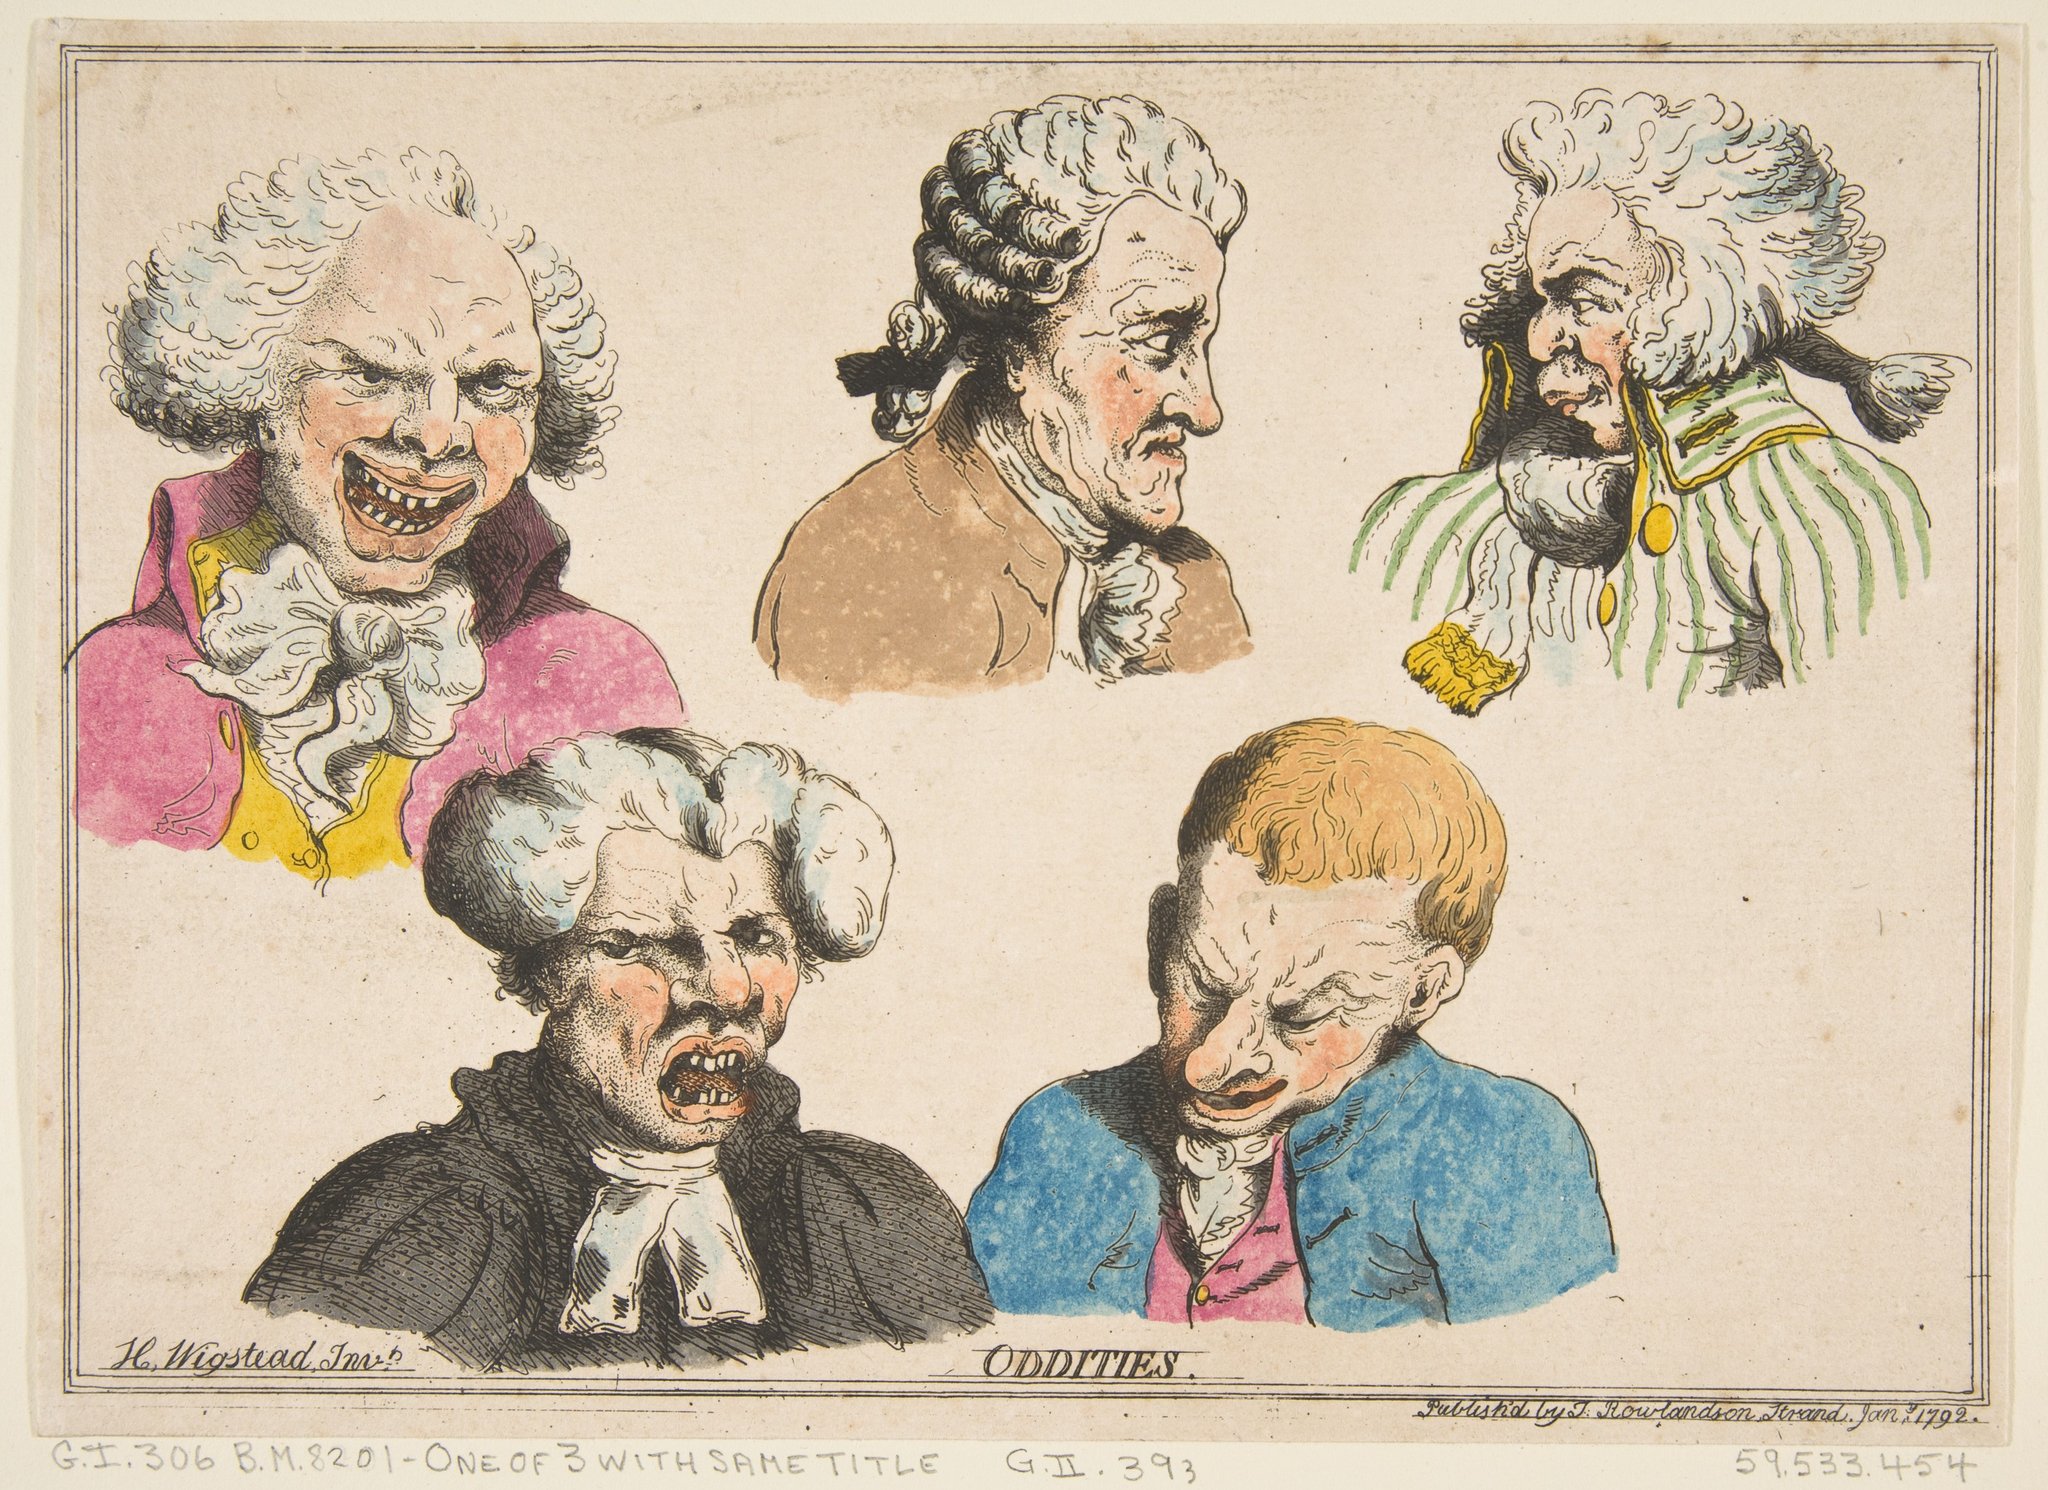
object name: print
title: Oddities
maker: thomas rowlandson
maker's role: artist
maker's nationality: british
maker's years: 1757-1827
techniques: etching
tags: men,caricature